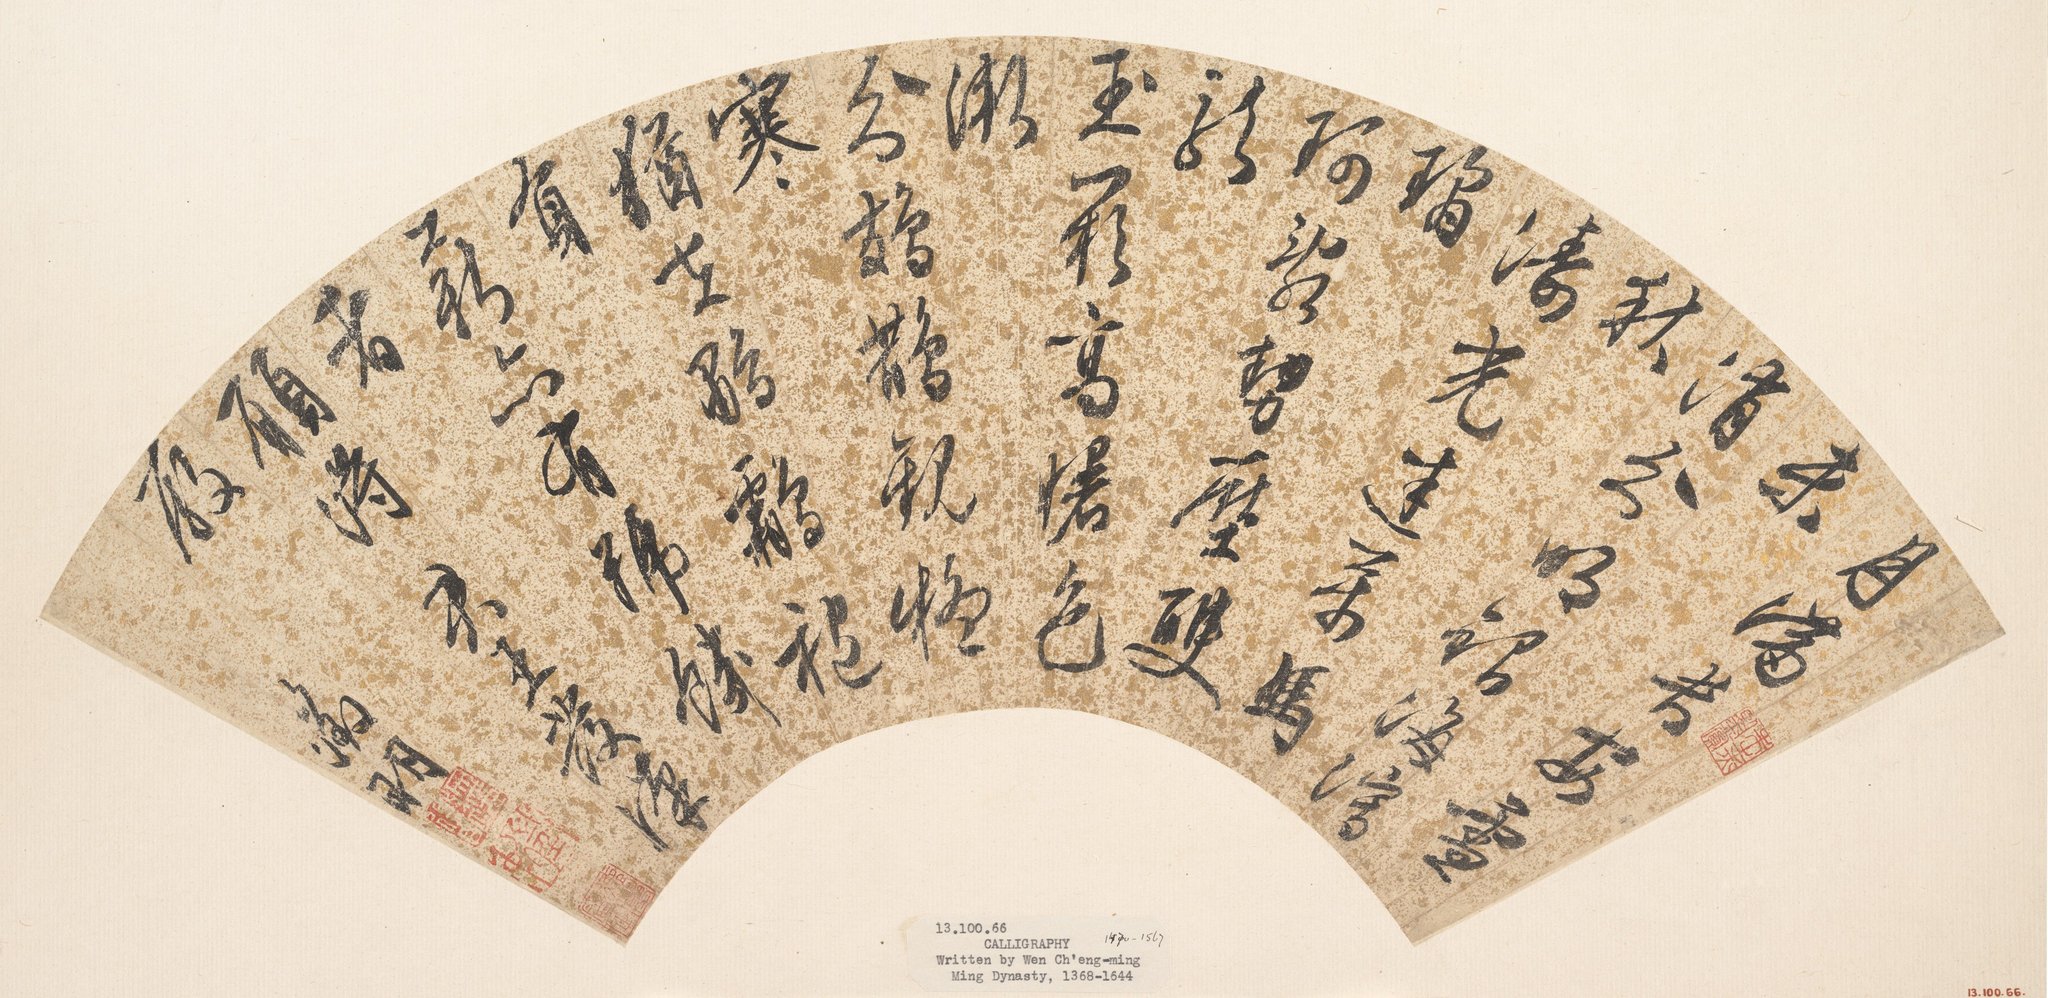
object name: folding fan mounted a an album leaf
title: Calligraphy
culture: chinese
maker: unidentified artist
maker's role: artist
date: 1601-1700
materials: gold, ink, paper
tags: calligraphy